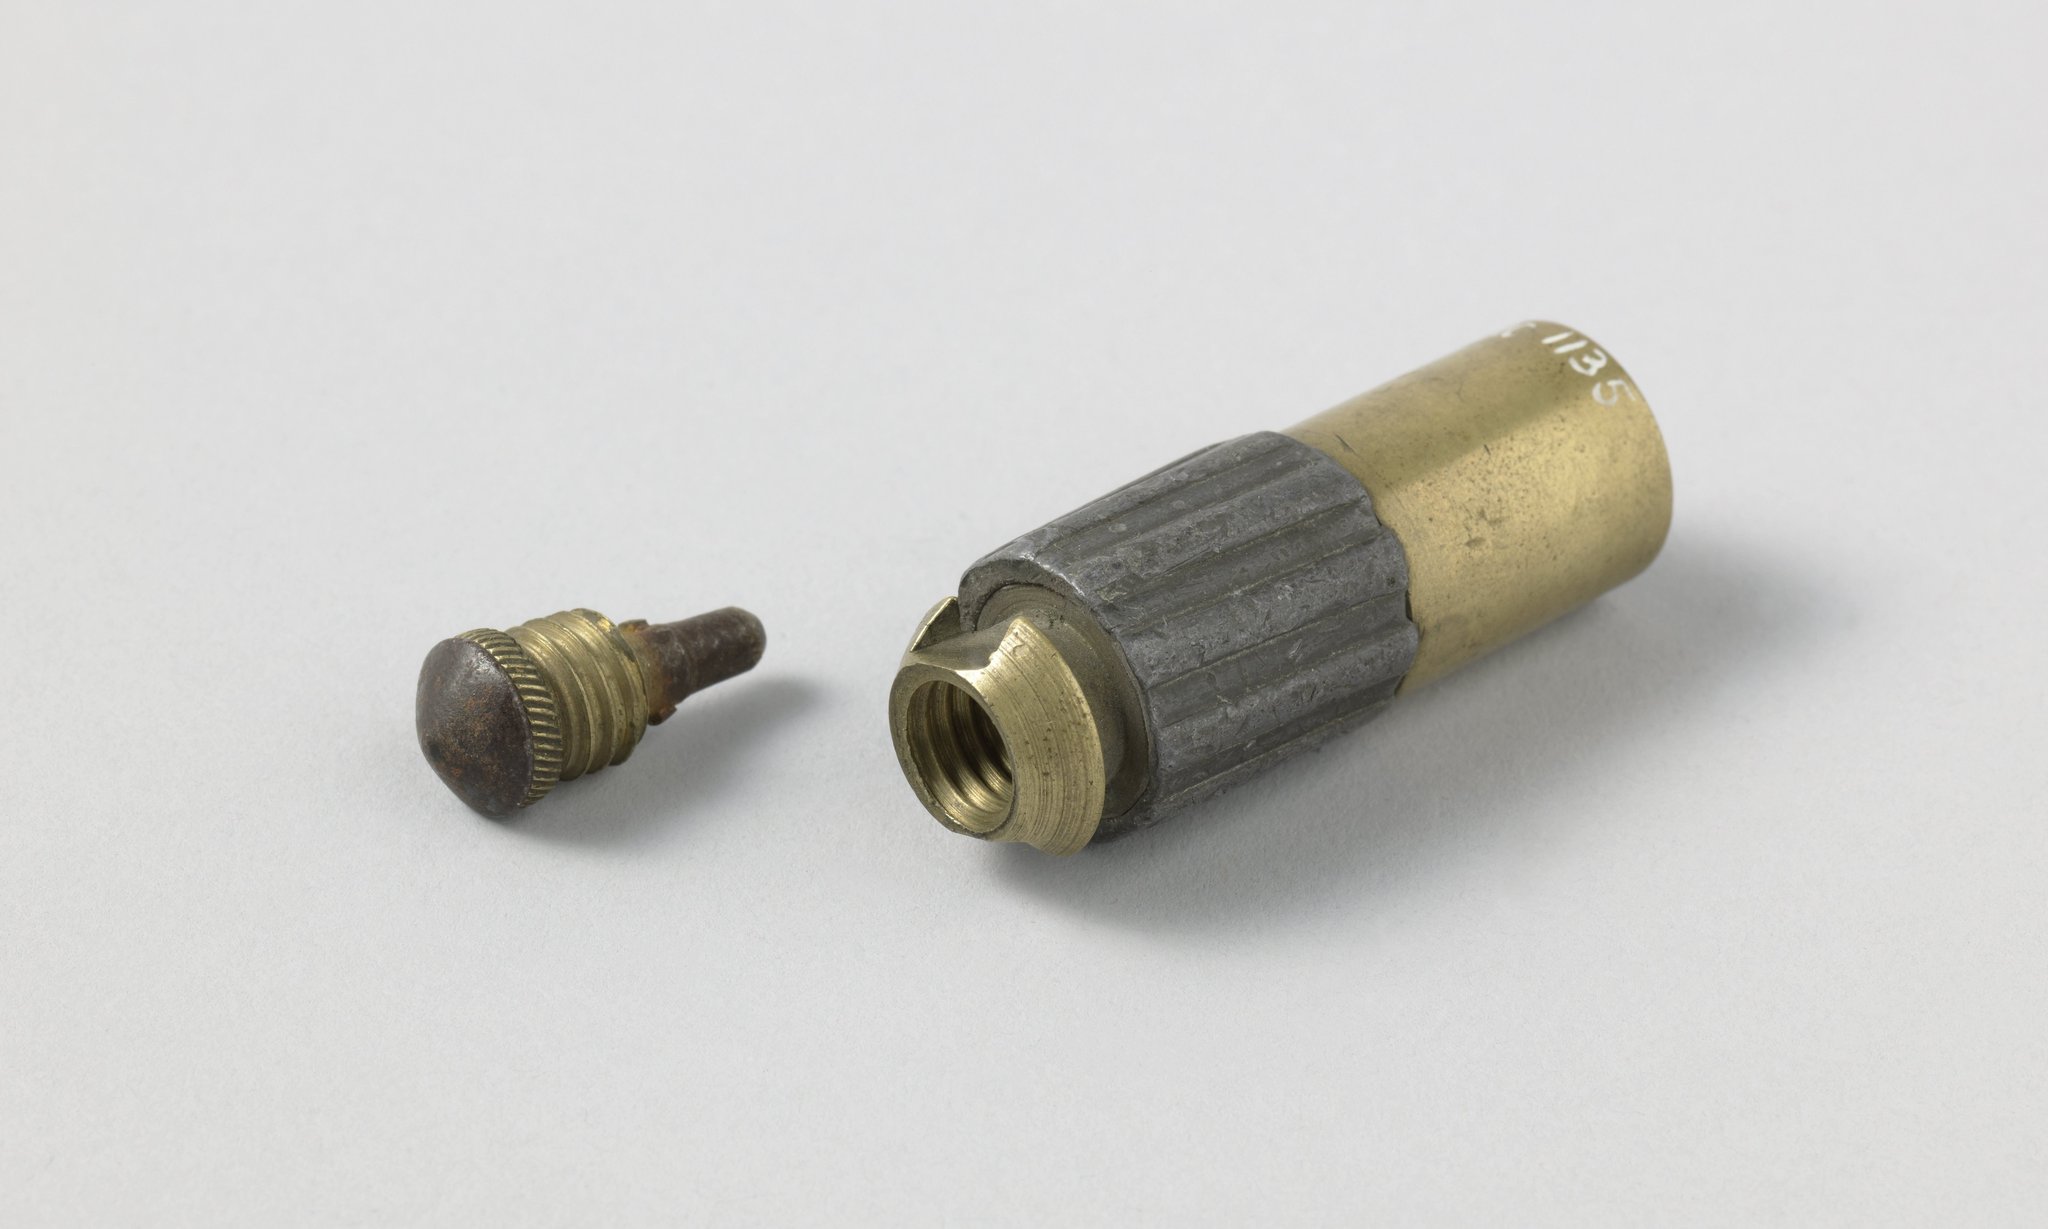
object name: bullet ammunition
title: Explosive Projectile for Whale Killing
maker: louis françois devisme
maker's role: print maker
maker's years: 1806-1874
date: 1840-1870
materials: brass, iron, lead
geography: paris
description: Exploderende kogel, incompleet. Het heeft een cilindrisch huis van messing, waarbij in de min of meer gepunte top een beweegbaar schoorsteentje is geschroefd. Op het schoorsteentje moet een slaghoedje geplaatst worden, dat binnen in het huis op een dwarsbalkje stoot als de punt een object raakt. De lading van de kogel dient langs de onderzijde ingebracht te worden; de afsluitdop daarvoor ontbreekt. Buiten loopt om de kogel een loden ring van trekkende velden, om de kogel geschikt te maken voor getrokken geschut.